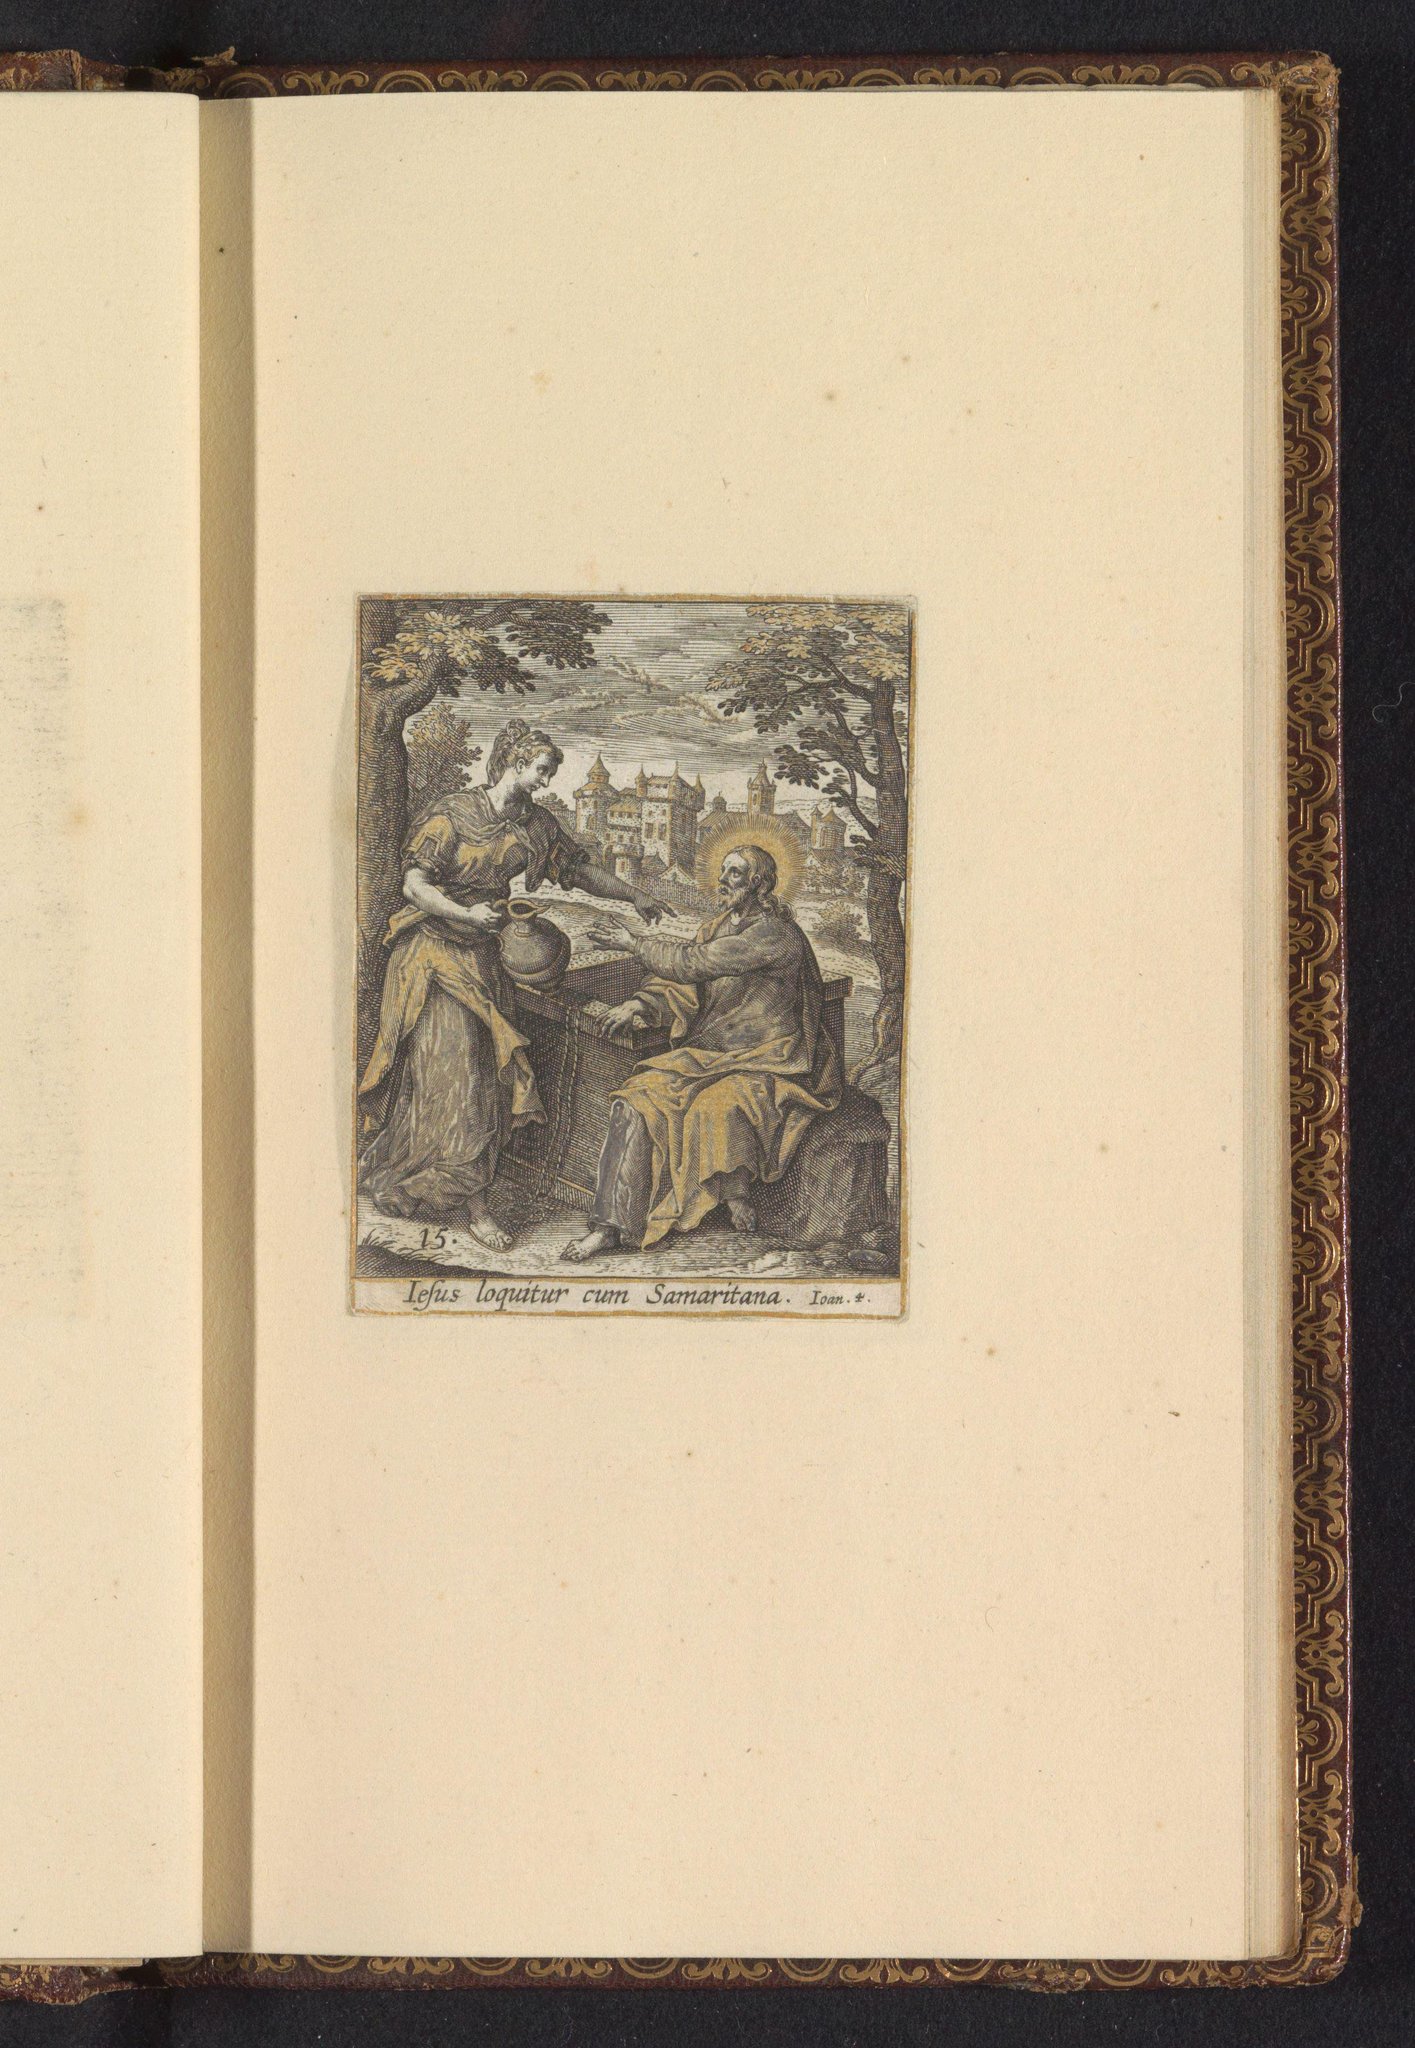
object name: print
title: Vita Iesu Salvatoris varijs iconibus ab Adriano Collaert expressa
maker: adriaen collaert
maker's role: draughtsman, print maker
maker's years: 1560-1618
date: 1580-1590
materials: gold, paper, silver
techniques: engraving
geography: antwerp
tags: christ and the woman of samaria: sitting at jacob's well he asks her for a drink from her jug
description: Christus en de Samaritaanse vrouw bij de put. Onderdeel van de prentserie over het leven van Christus: Vita Iesu Salvatoris varijs iconibus ab Adriano Collaert expressa. In prentalbum met twee reeksen van respectievelijk 34 en 25 gravures met scènes uit het leven en het lijdensverhaal van Christus.